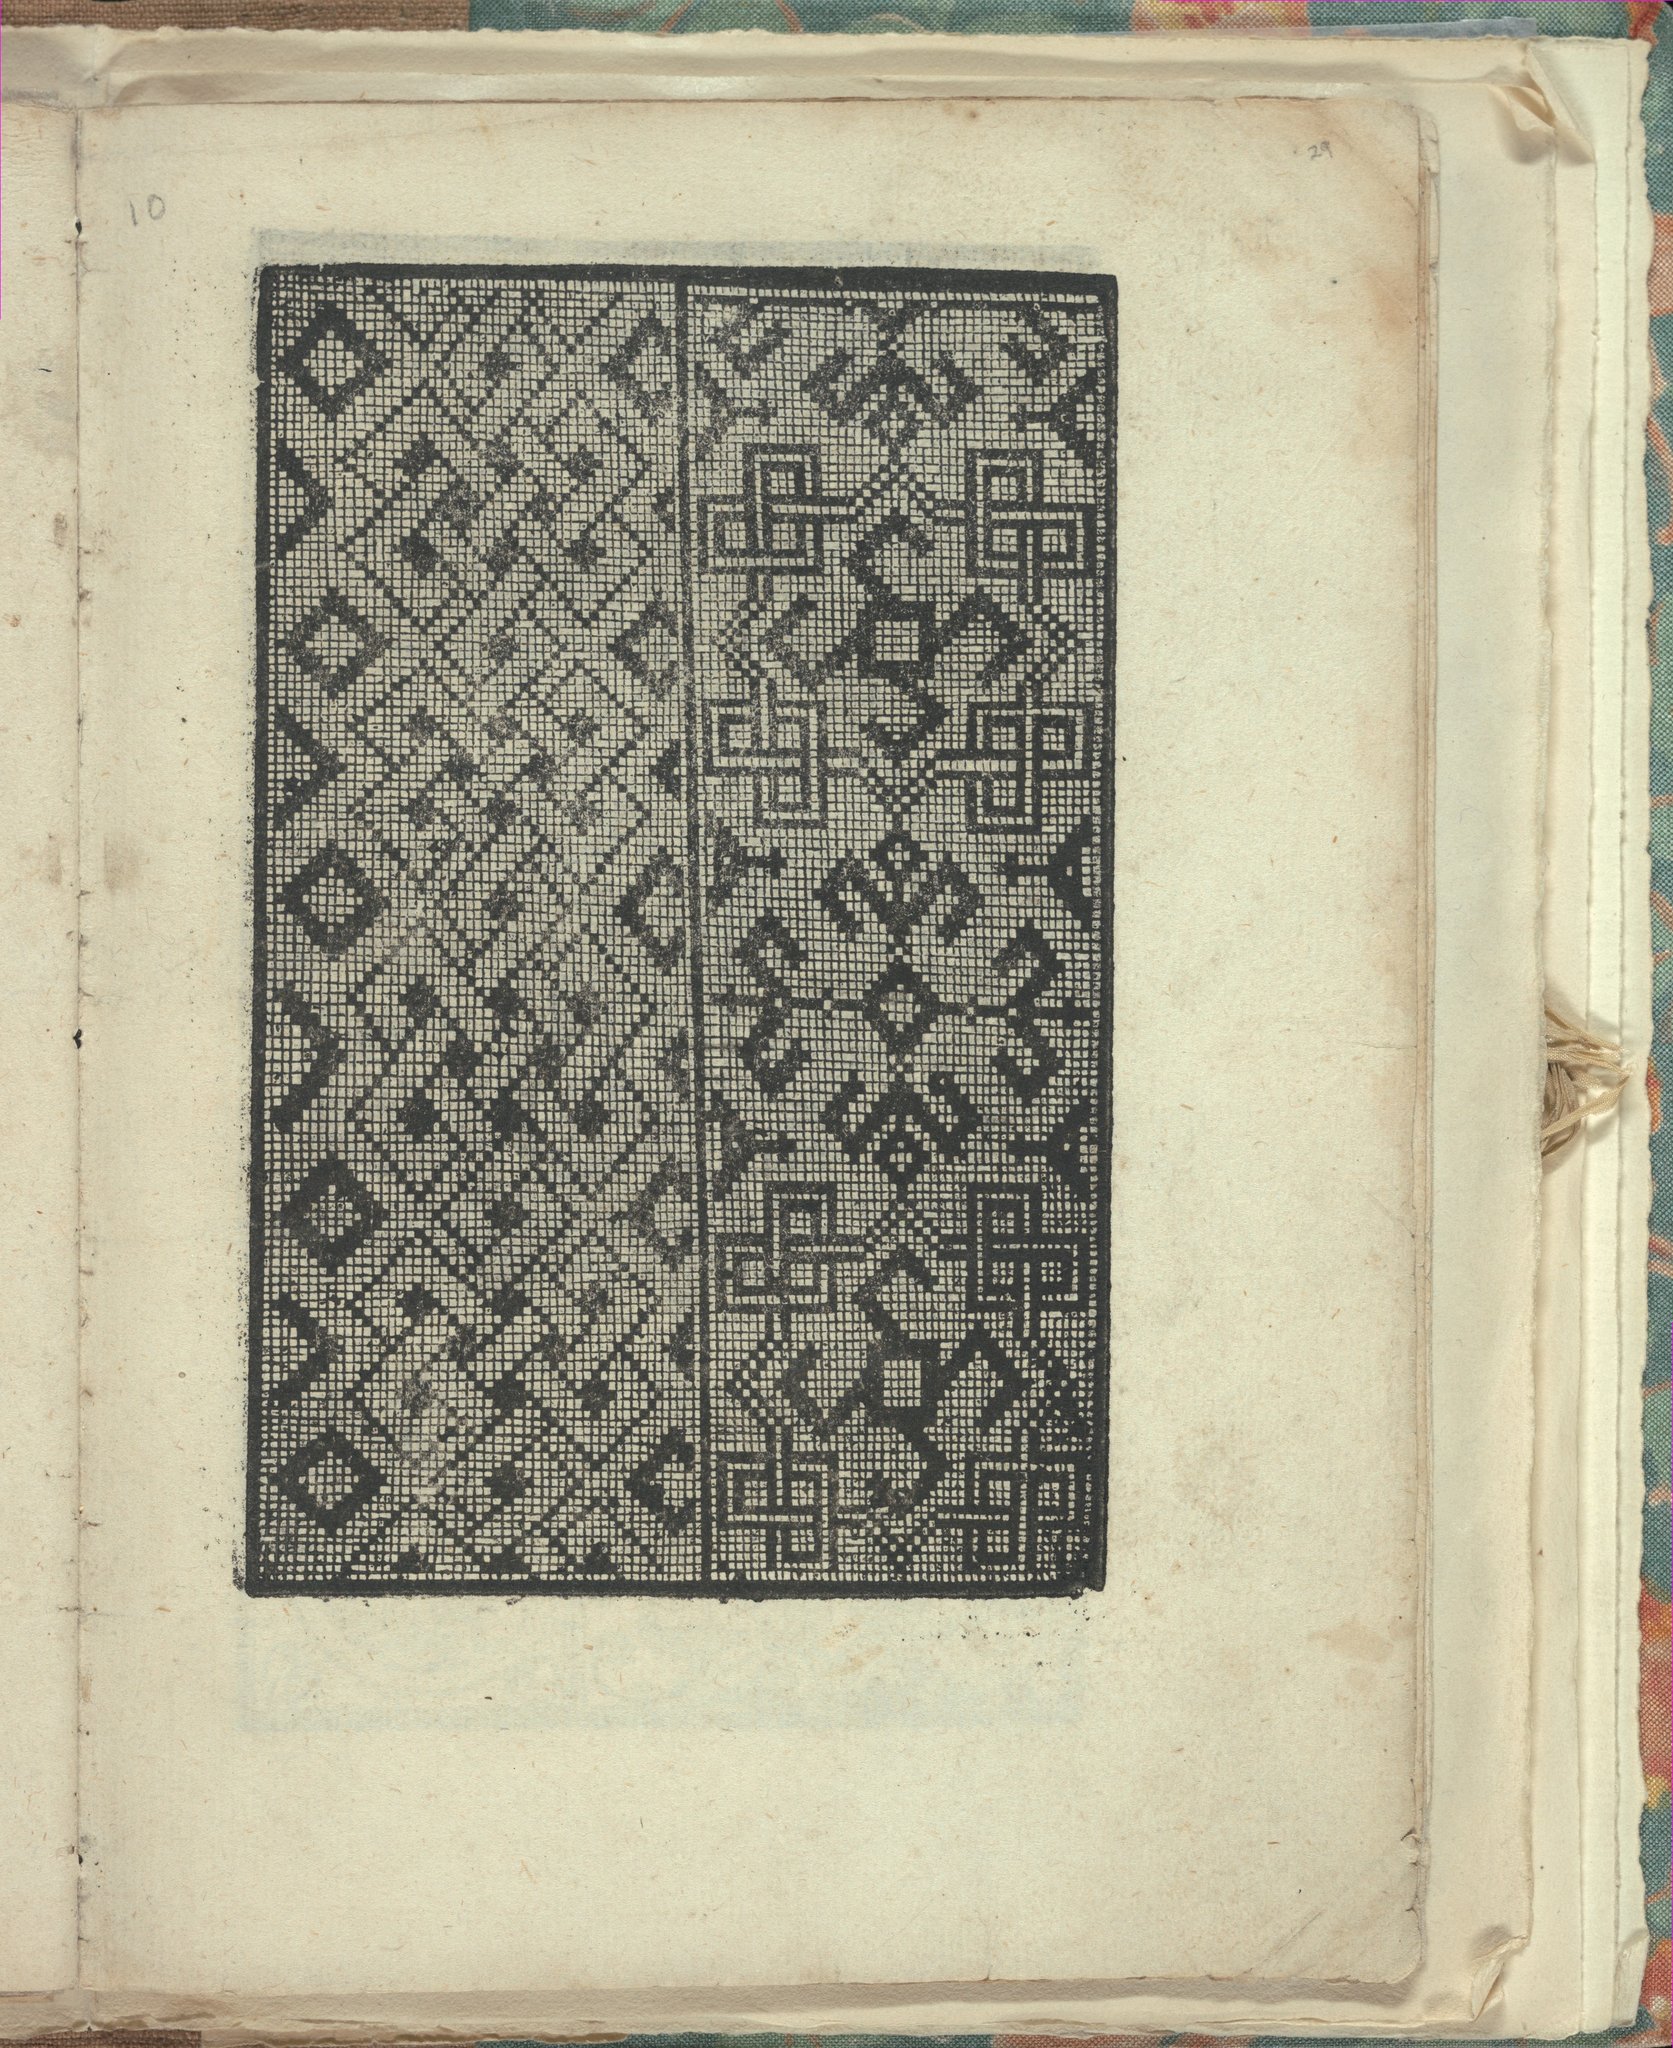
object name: book print ornament architecture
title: Opera Nova Universali intitulata Corona di racammi, page 29 (recto)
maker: giovanni andrea vavassore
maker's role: publisher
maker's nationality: italian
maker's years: 1530-1573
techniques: woodcut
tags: ornament